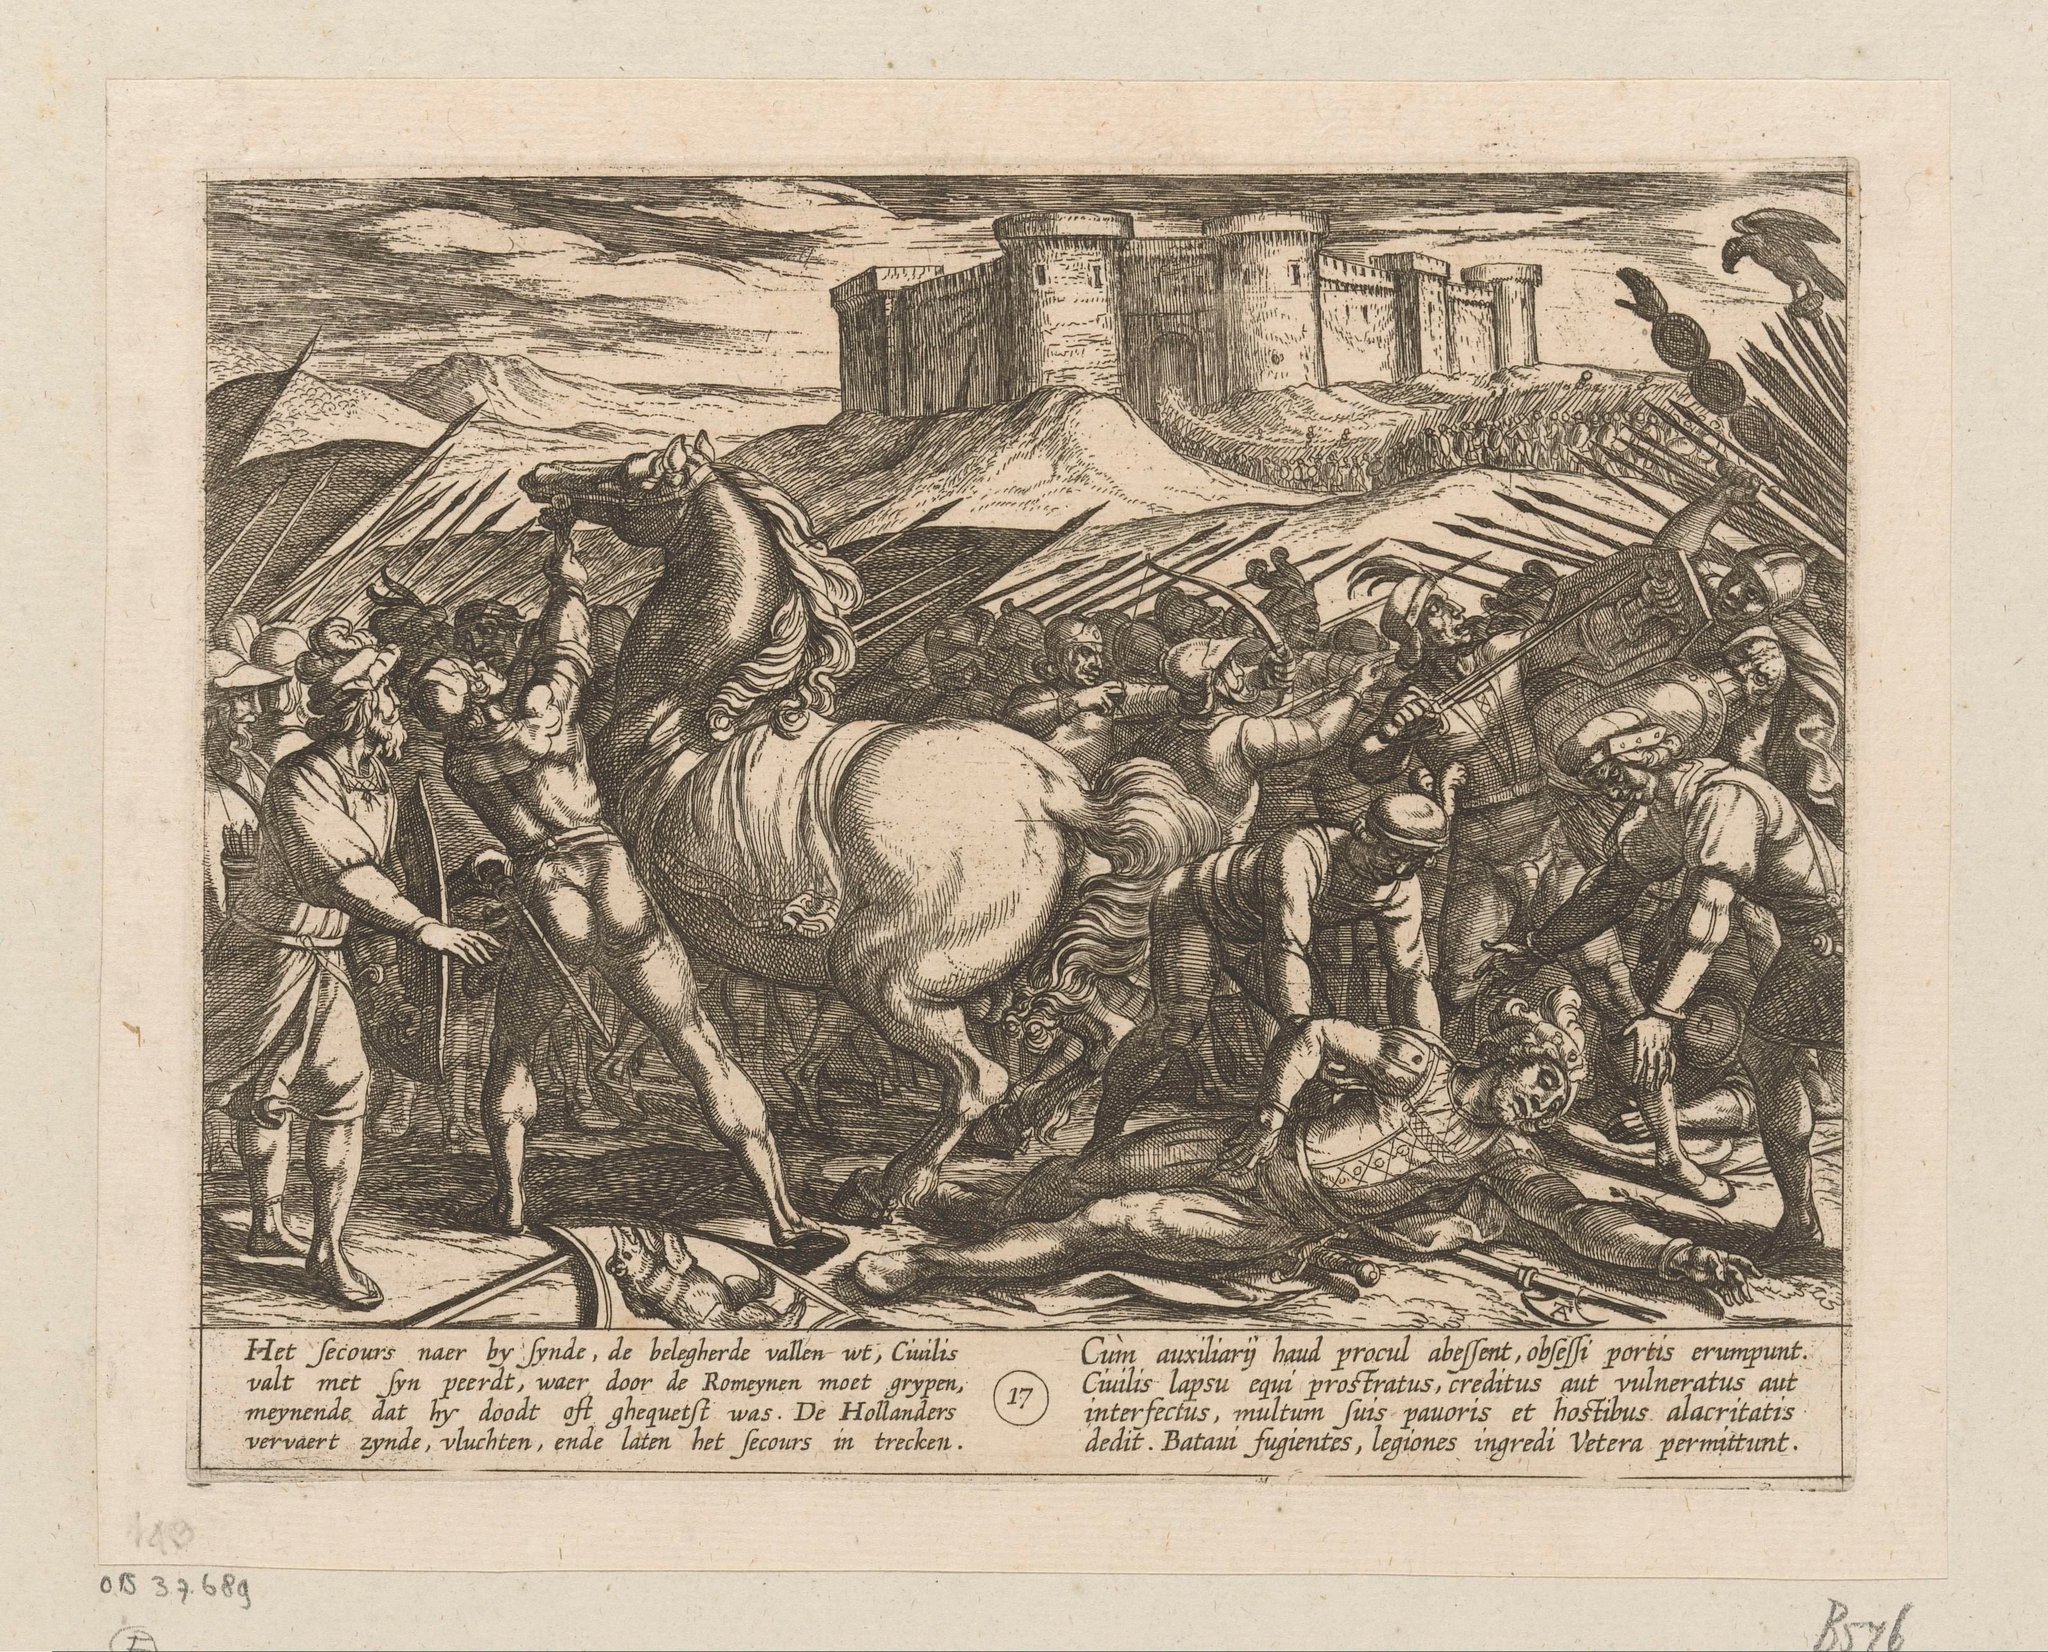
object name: history print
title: Romeinen misleid te denken dat Civilis dood of gewond is, 69-70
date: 1612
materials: paper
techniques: etching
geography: italy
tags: battle, fighting in general, extinct, 'historical' peoples (with name), netherlands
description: Civilis valt van zijn paard om de Romeinen te misleiden en te laten denken dat hij dood of gewond is. Prent nummer 17 in de serie prenten over de Bataafse Opstand: Batavorum cum Romanis bellum / à Corn. Tacito lib. IV & V. : Hist. olim descriptum, figuris nunc aeneis expressum, auctore Othone Vaenio Lugdunobatava = De Batavische oft oude Hollandtsche oorloghe teghen de Romeynen. Otto Vaenius, Antwerpen 1612. Onderaan twee verzen van vier regels in het Nederlands en in het Latijn. Zonder tekst op achterzijde.